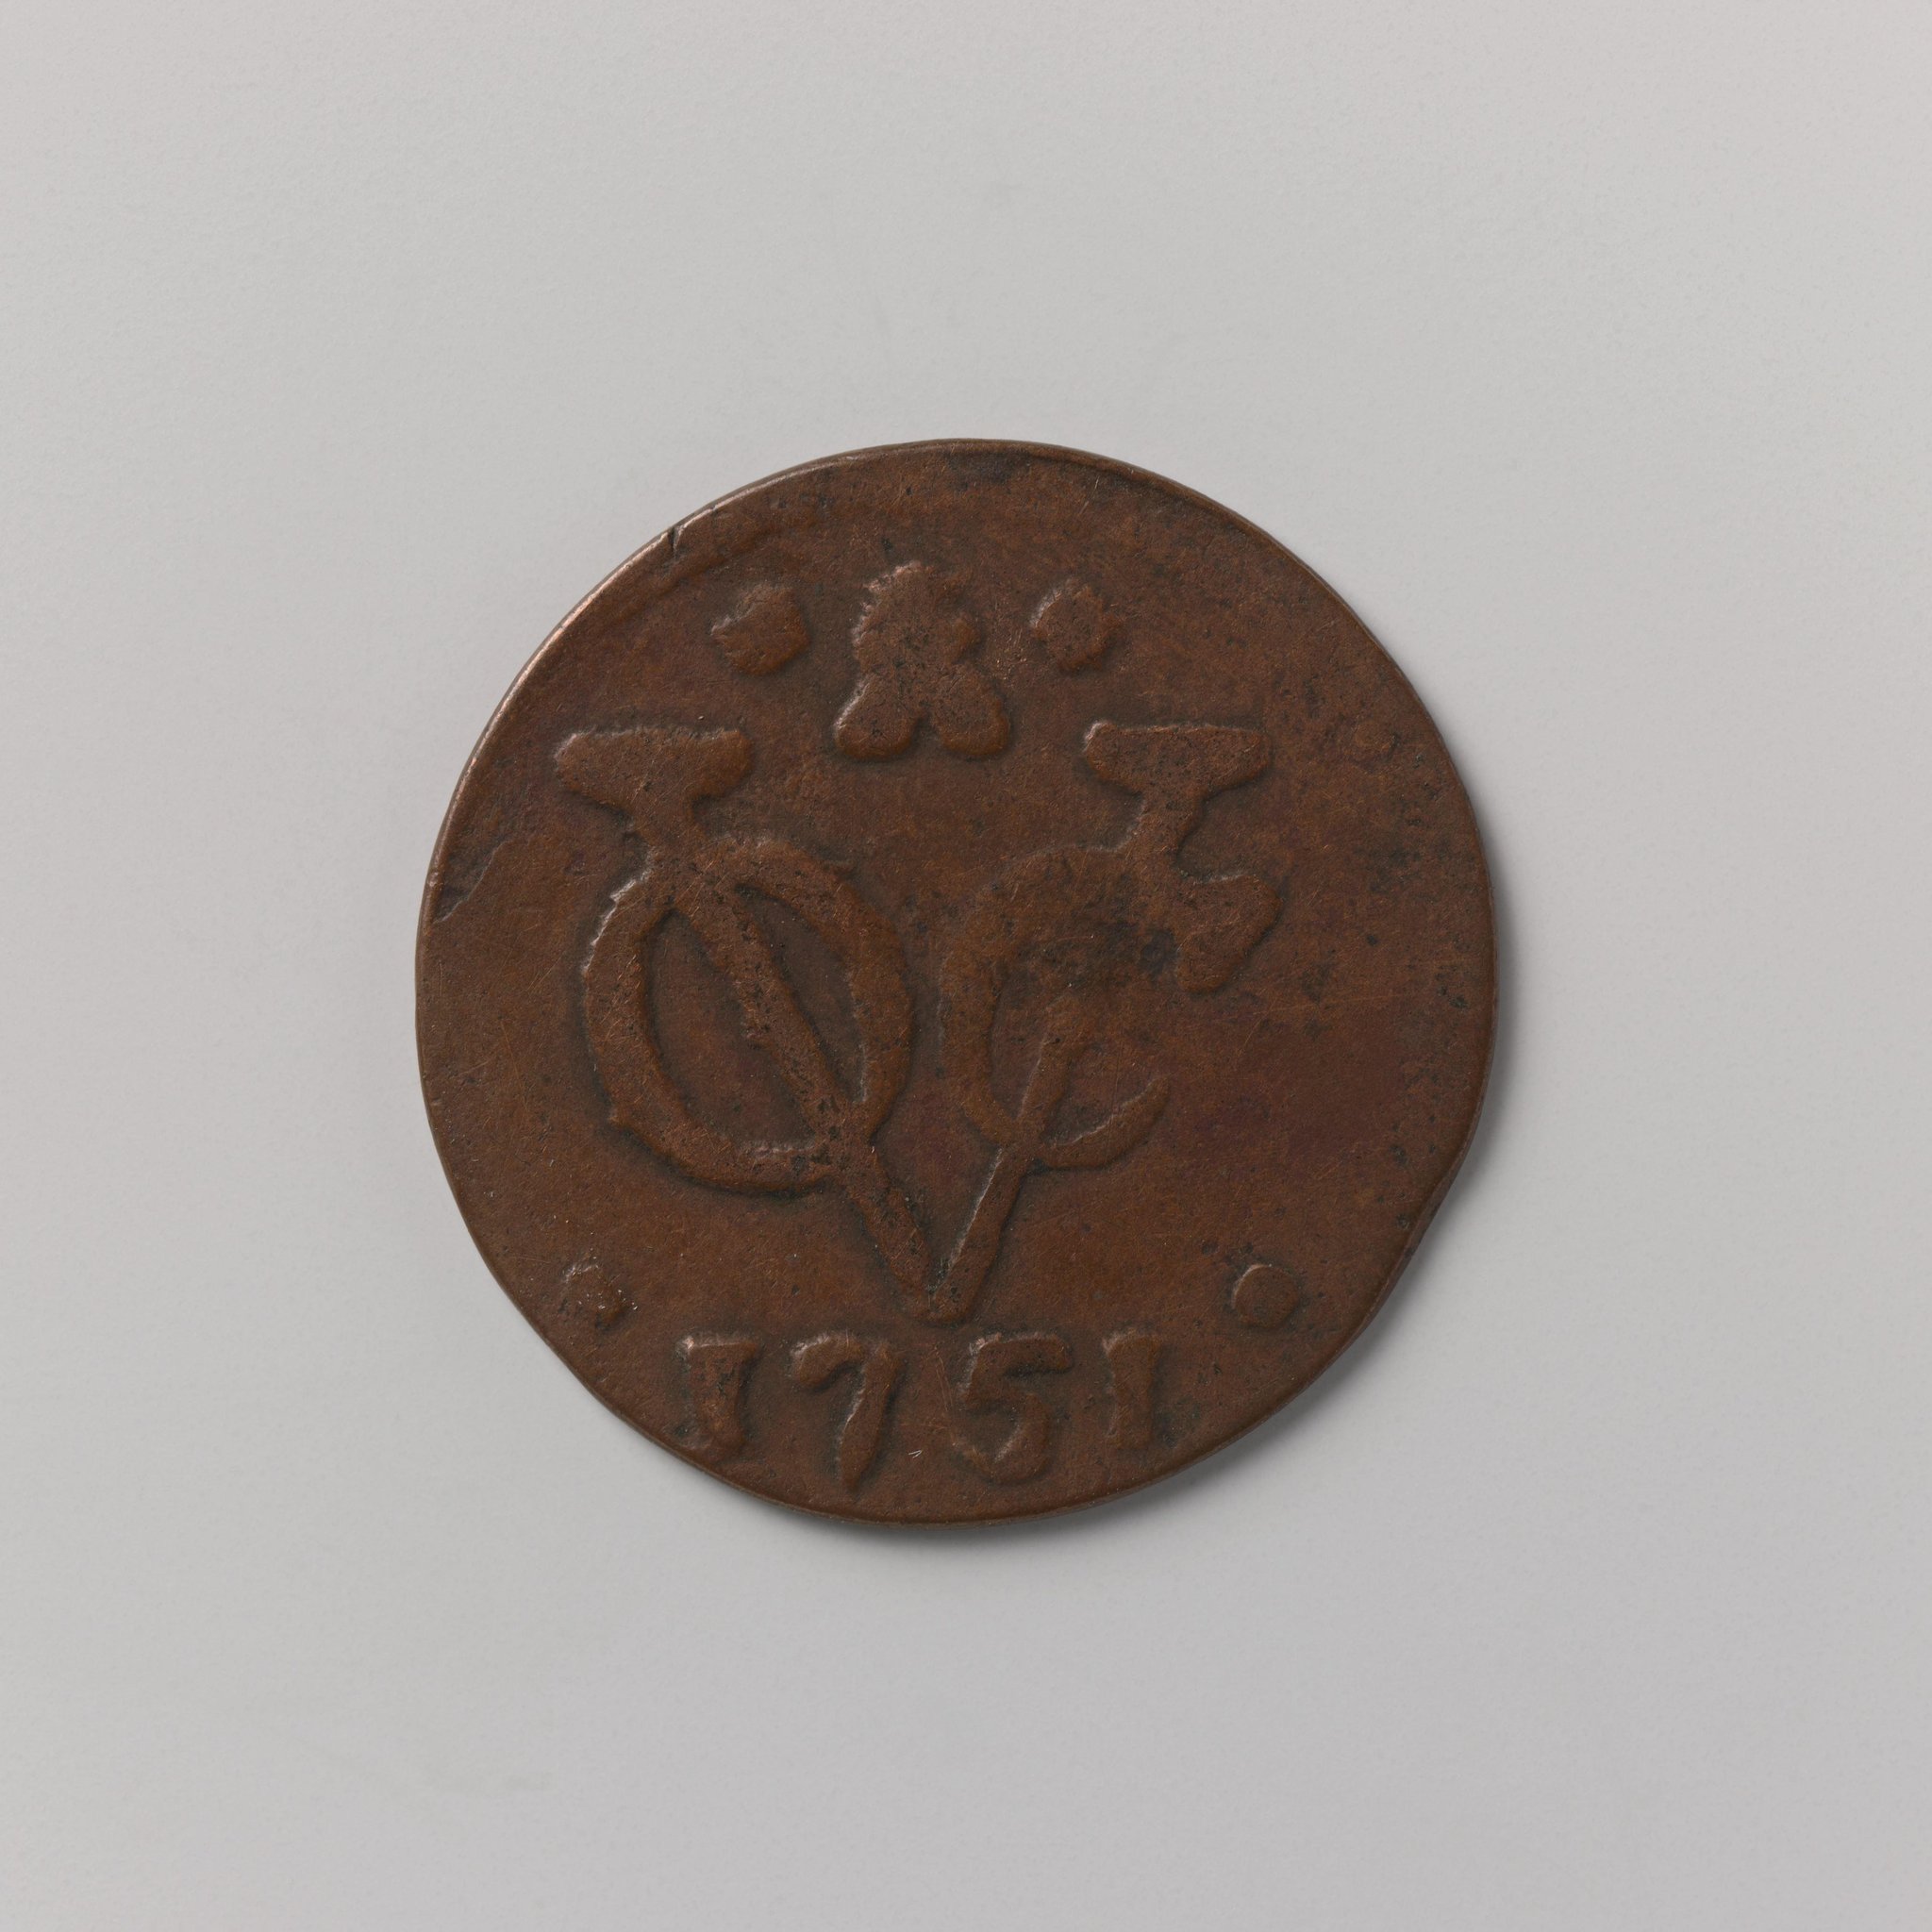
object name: coin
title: Duit van de VOC uit Zeeland, 1751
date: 1751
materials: copper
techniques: striking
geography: middelburg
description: Koperen munt. Voorzijde: gekroond wapenschild van Zeeland. Keerzijde: monogram van de VOC, waarboven muntteken en waaronder jaartal. Gladde rand.